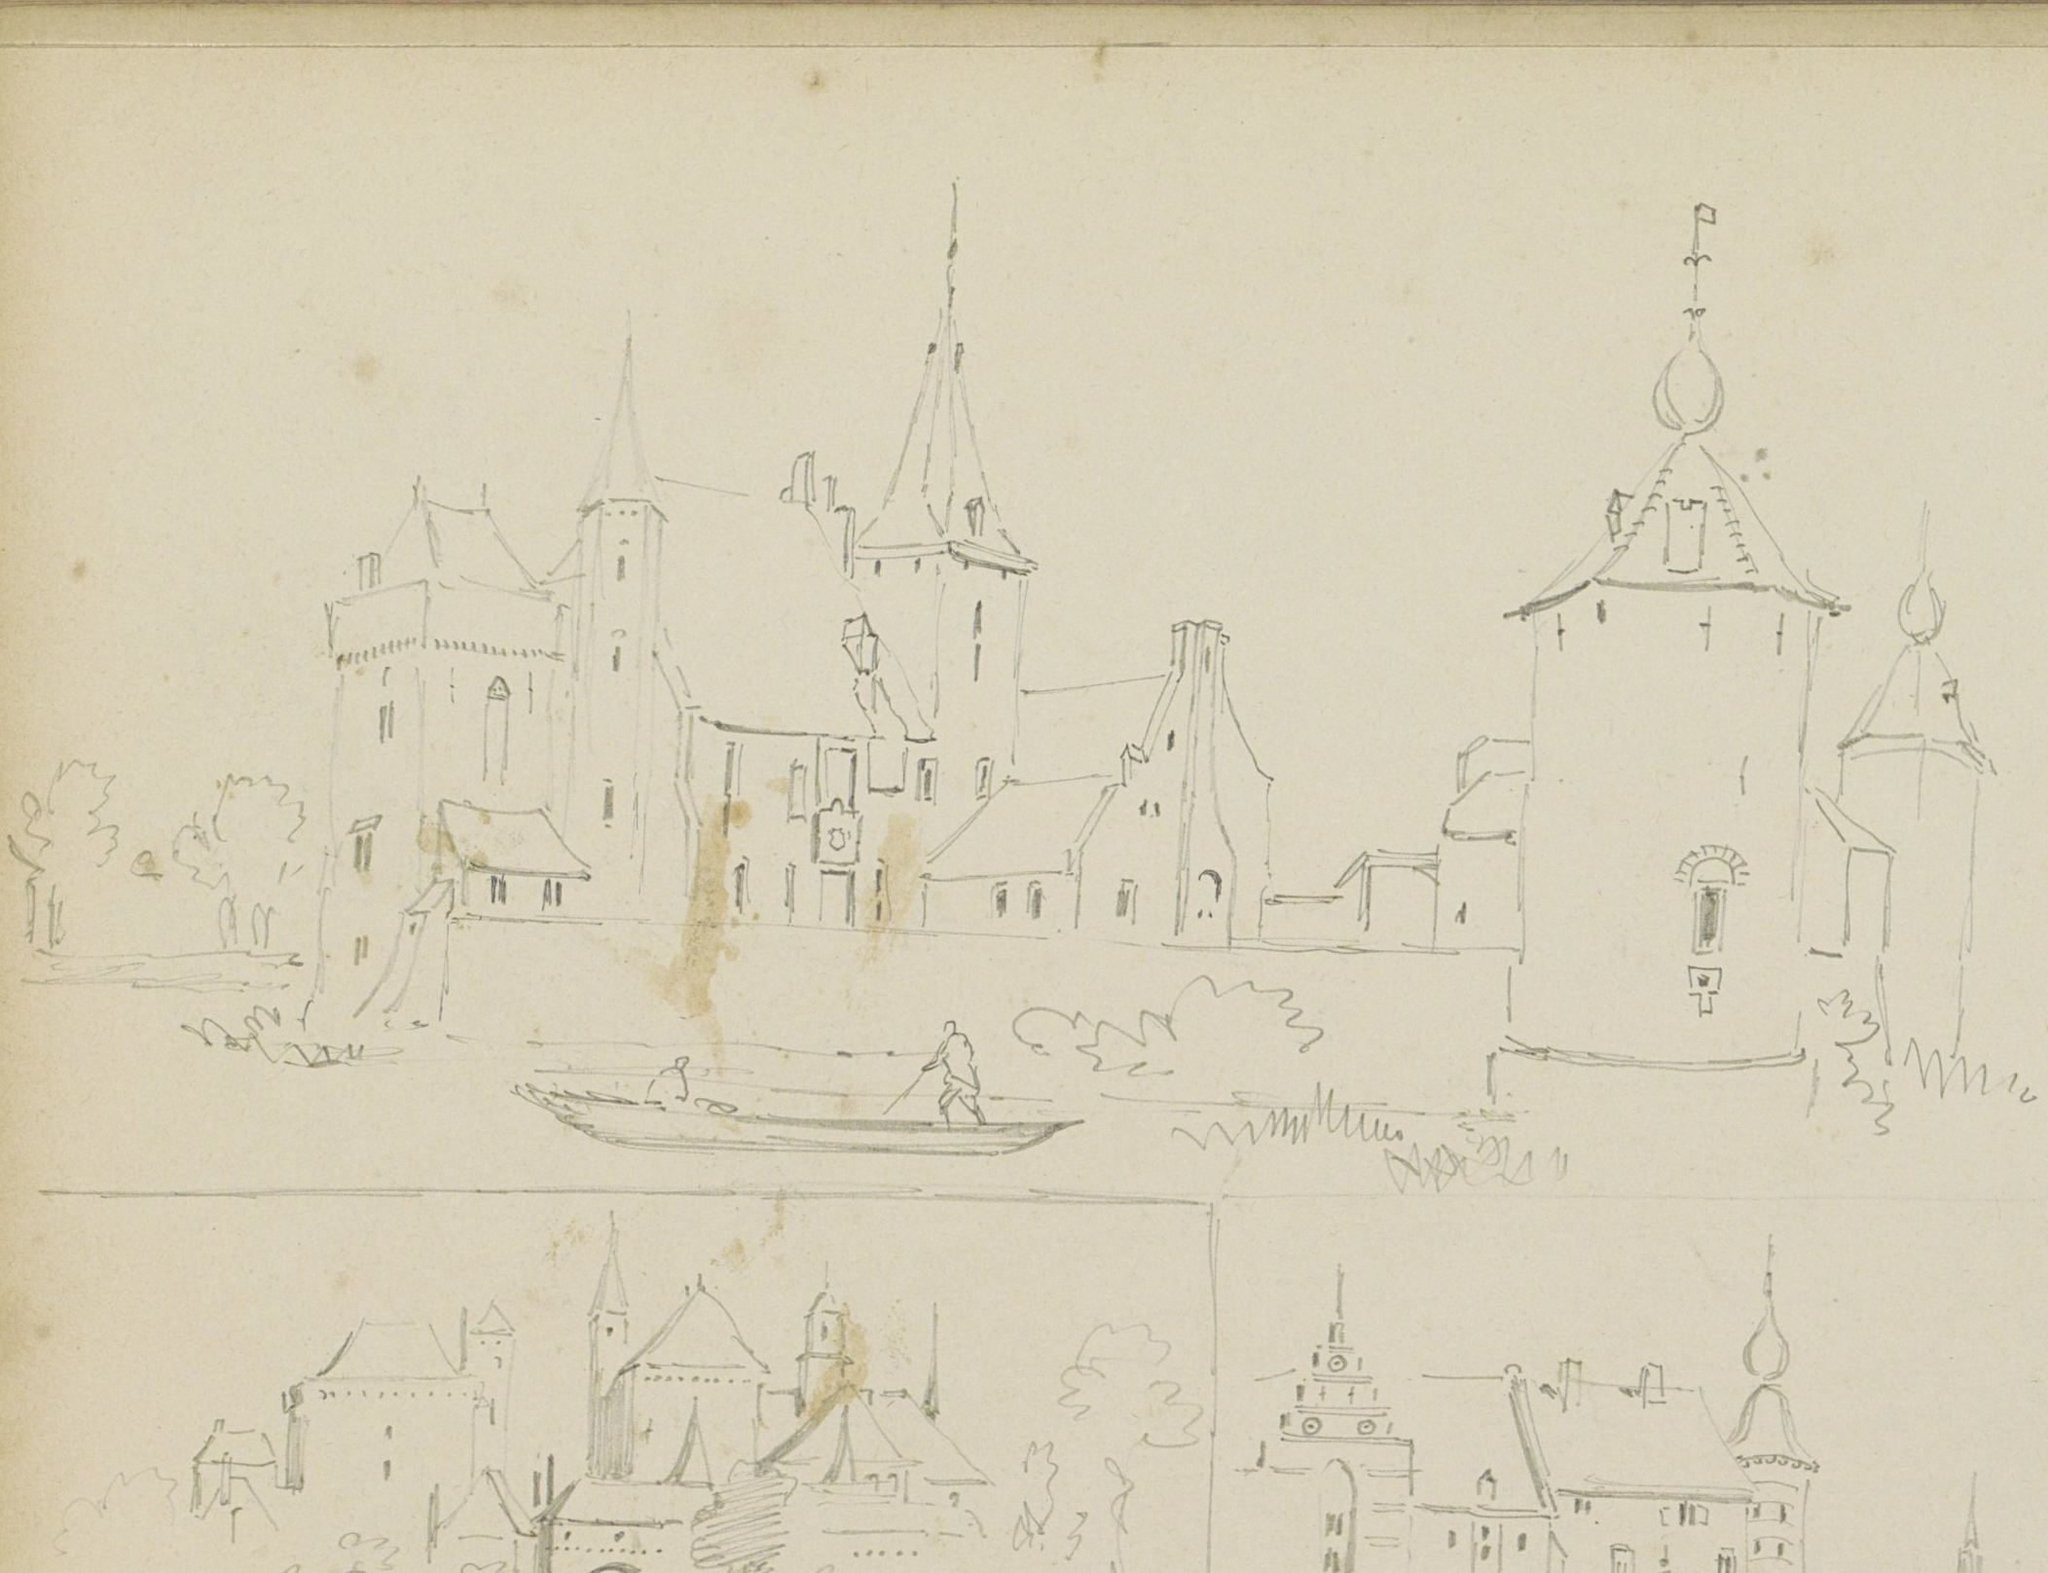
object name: sketchbook leaf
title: Studieblad met gebouwen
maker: adrianus eversen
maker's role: draughtsman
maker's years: 1818-1897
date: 1828-1897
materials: paper, pencil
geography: netherlands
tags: castle, rowing-boat, canoe, etc., civic architecture; edifices; dwellings, tower (of house or building)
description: Studieblad met gebouwen. Boven twee personen in een roeiboot voor een kasteel of buitenplaats. Blad 23 verso uit een schetsboek met 41 bladen.